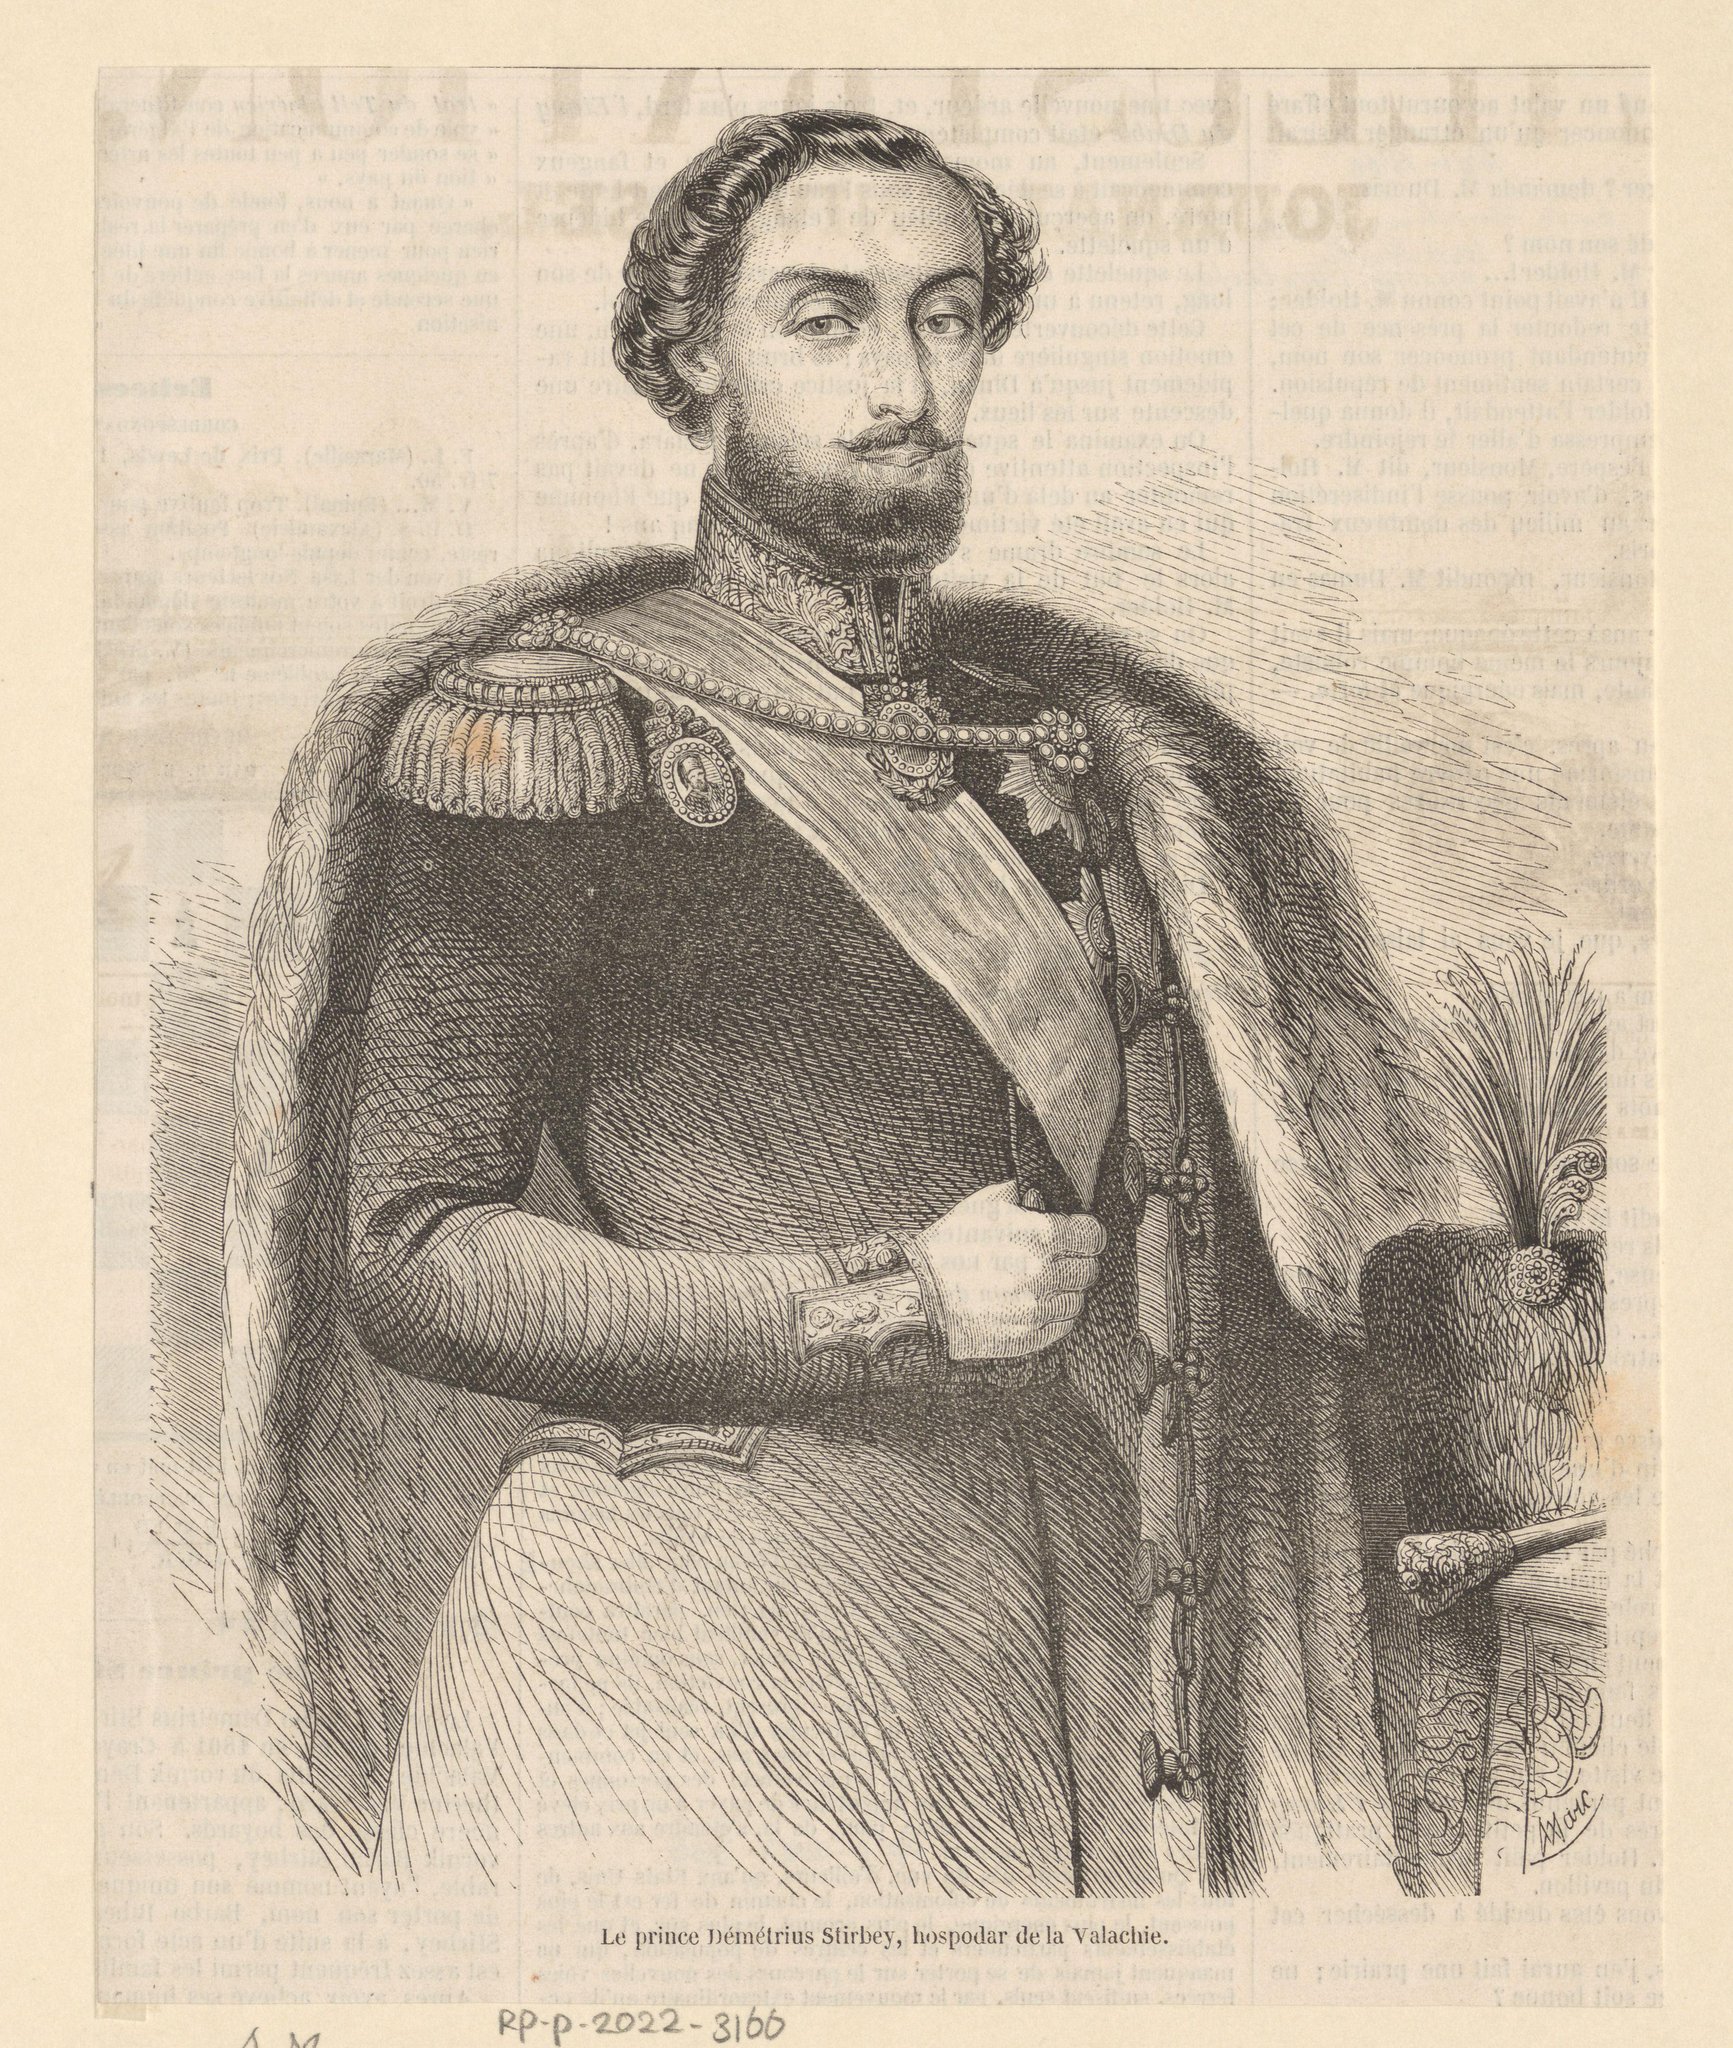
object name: print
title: Portret van Barbu Dimitrie Știrbei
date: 1854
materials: paper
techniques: letterpress printing, engraving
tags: politician, historical persons, politician, e.g. party leader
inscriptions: stamp: ‘JVB’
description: Prent uit: L'illustration, journal universel 24 (1854), 21 oktober 1854.